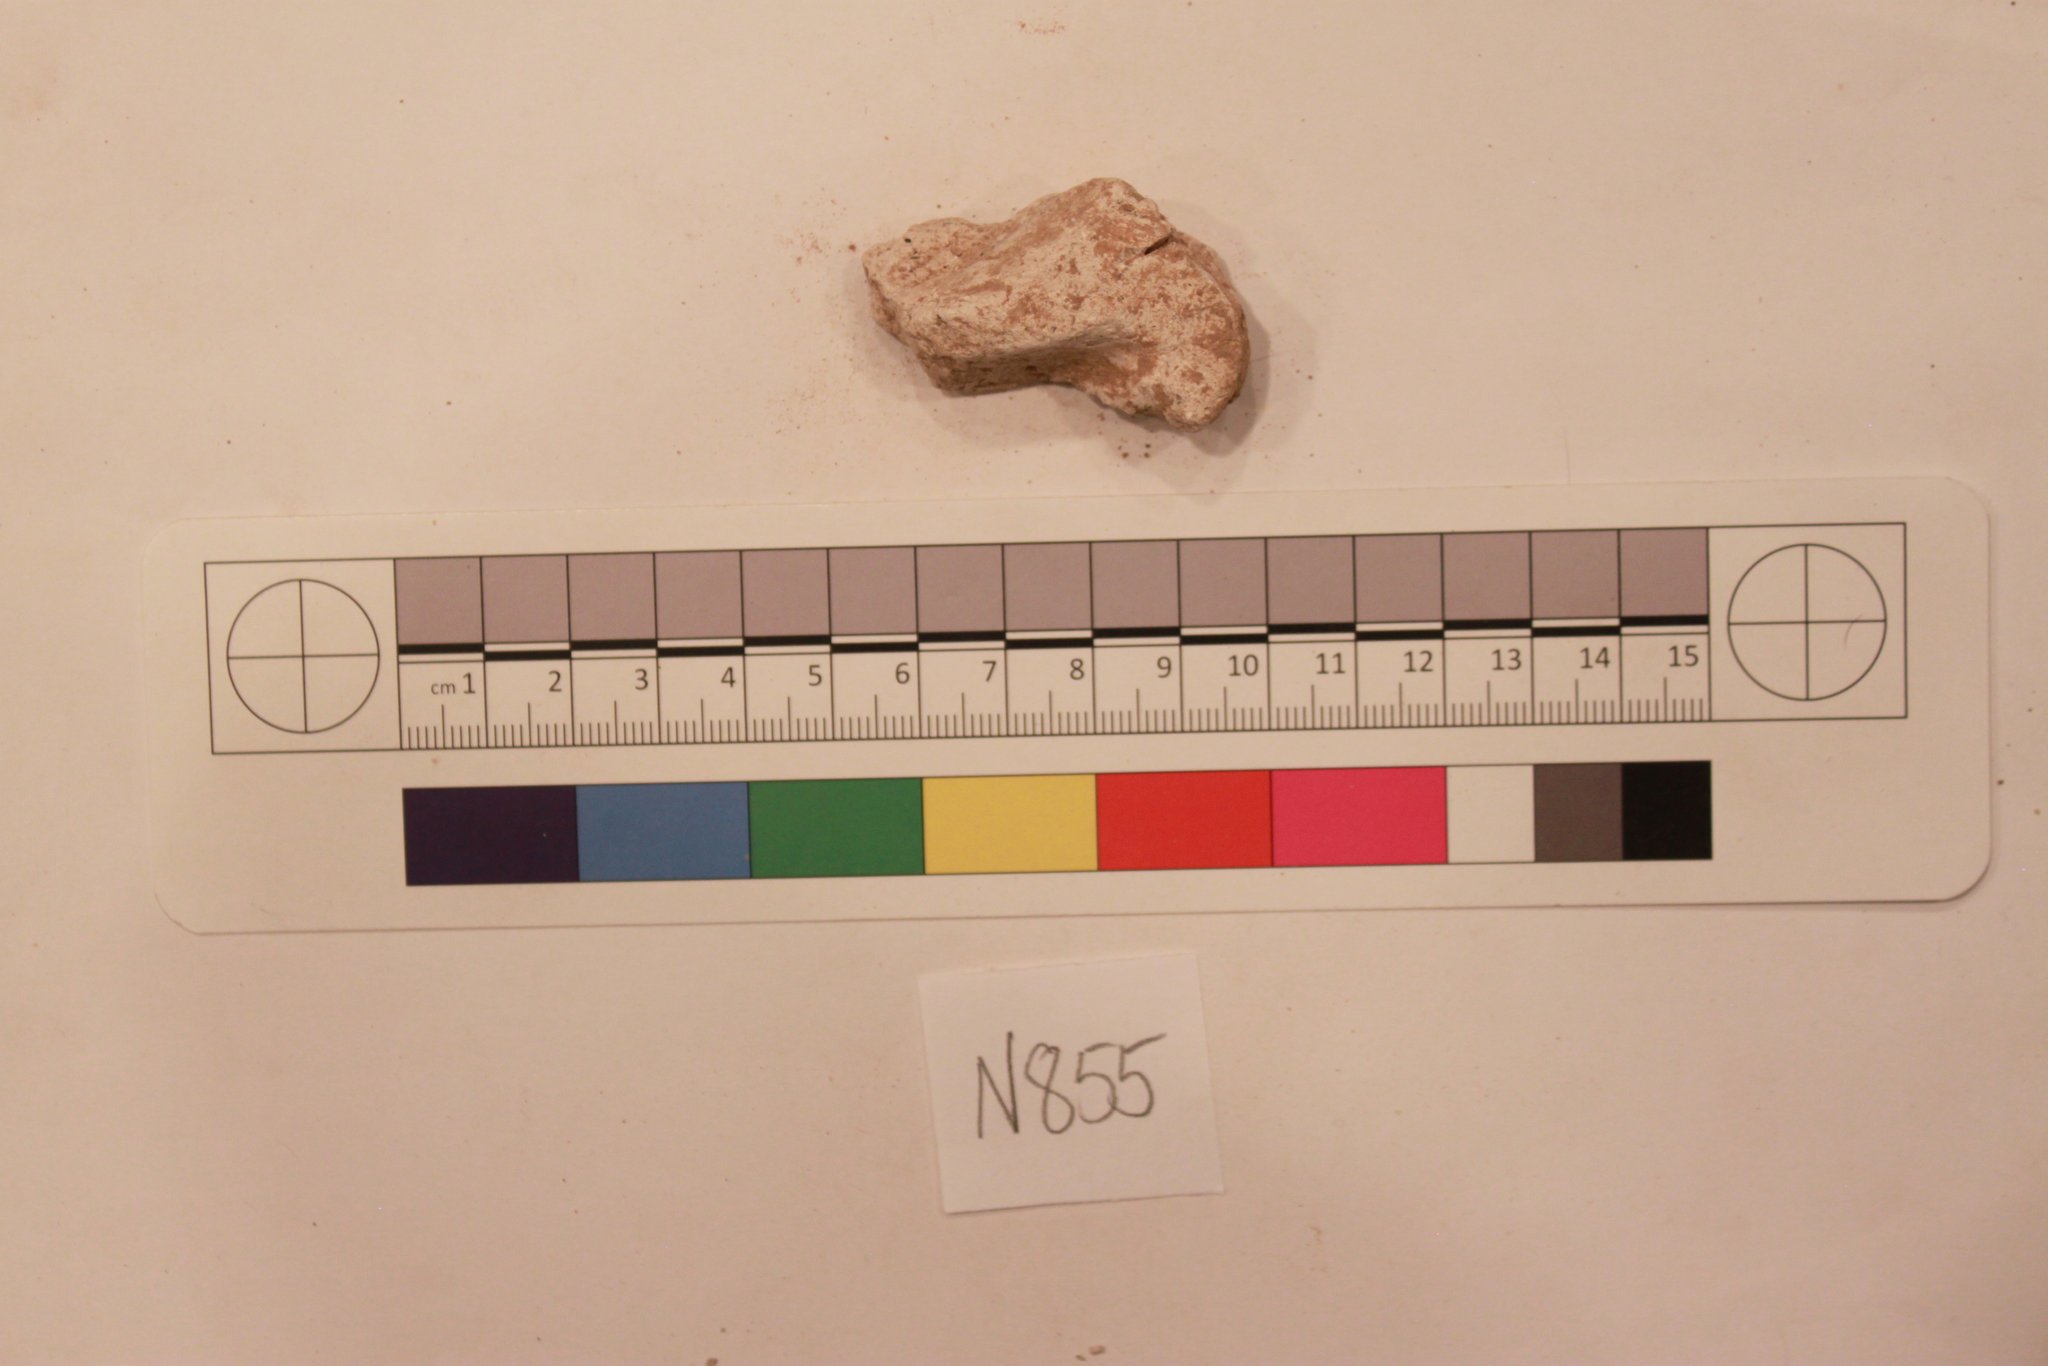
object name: fragment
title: Stucco Fragment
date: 701-1200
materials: plaster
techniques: carving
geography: iran